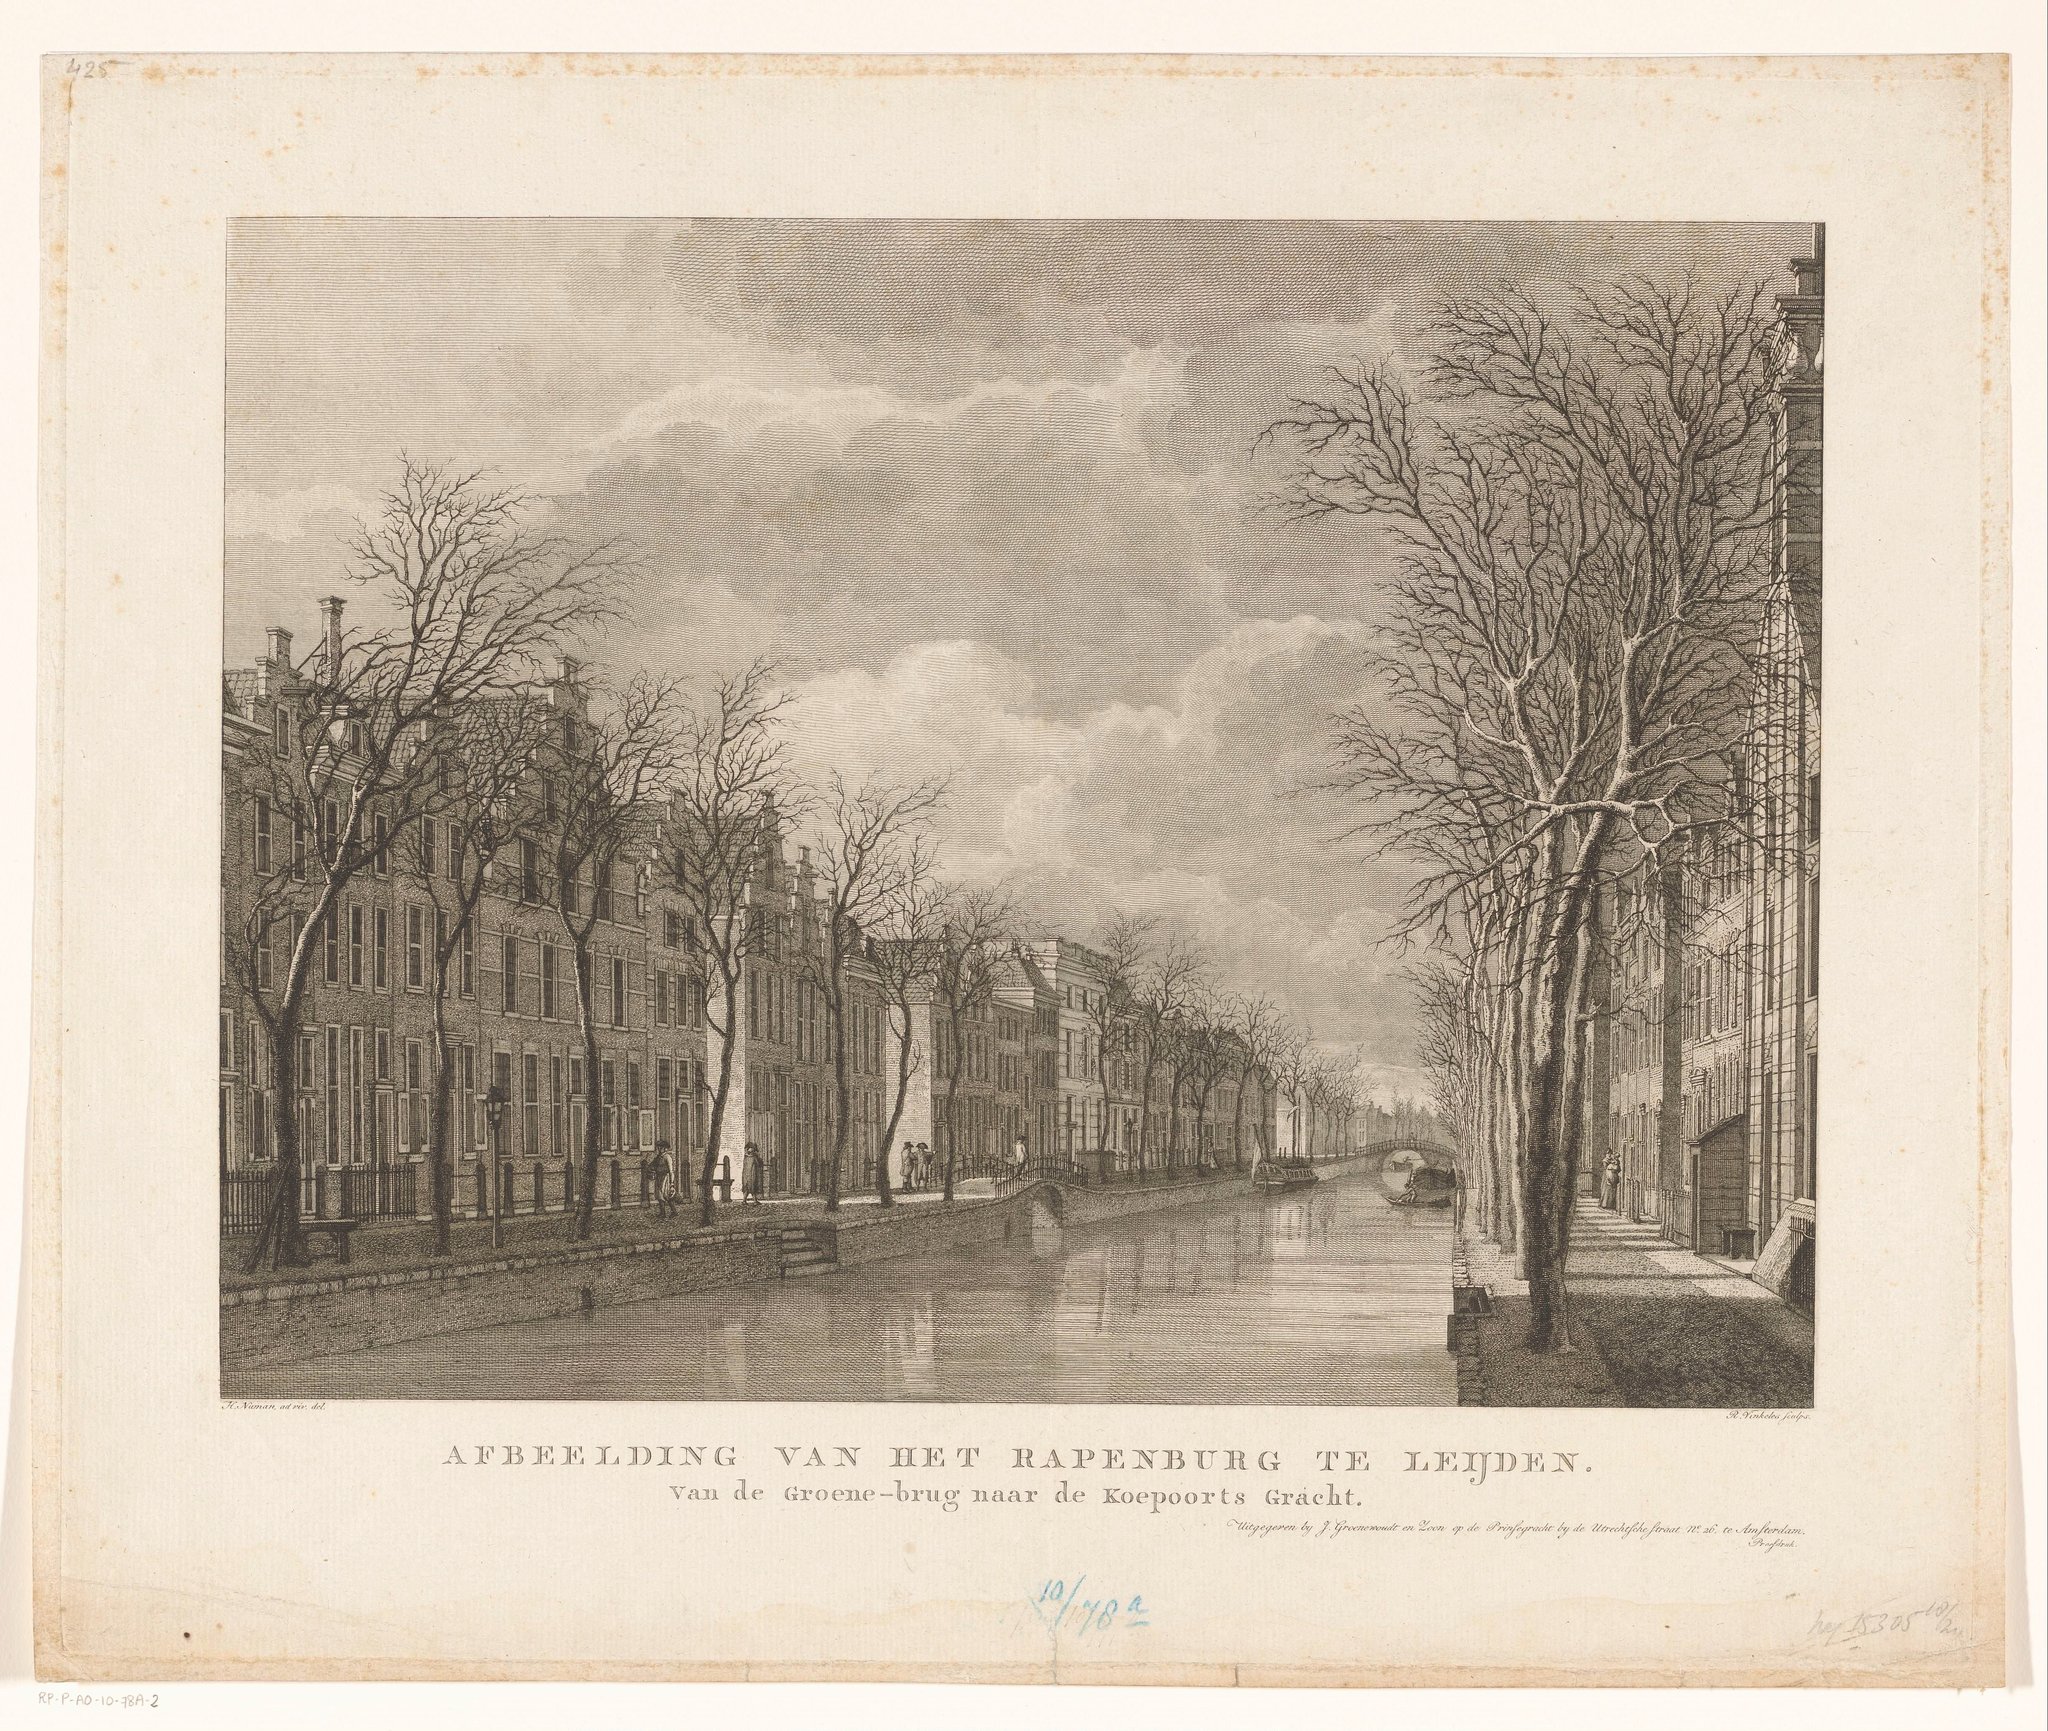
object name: print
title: Afbeelding van het Rapenburg te Leijden. Van de Groene-brug naar de Koepoorts Gracht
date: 1807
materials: paper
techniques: engraving, etching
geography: leiden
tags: city-view in general; 'veduta'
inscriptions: collector's mark: Lugt 195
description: Gezicht op het het Steenschuur, een gracht in het verlengde van het Rapenburg, te Leiden, in welstand vóór de buskruitramp van 12 januari 1807. Dit stuk is eigenlijk het Steenschuur, kijkend vanaf de Groenebrug naar de Nieuwsteegbrug in de verte. Aan de rechteroever ligt het kruitschip afgemeerd.